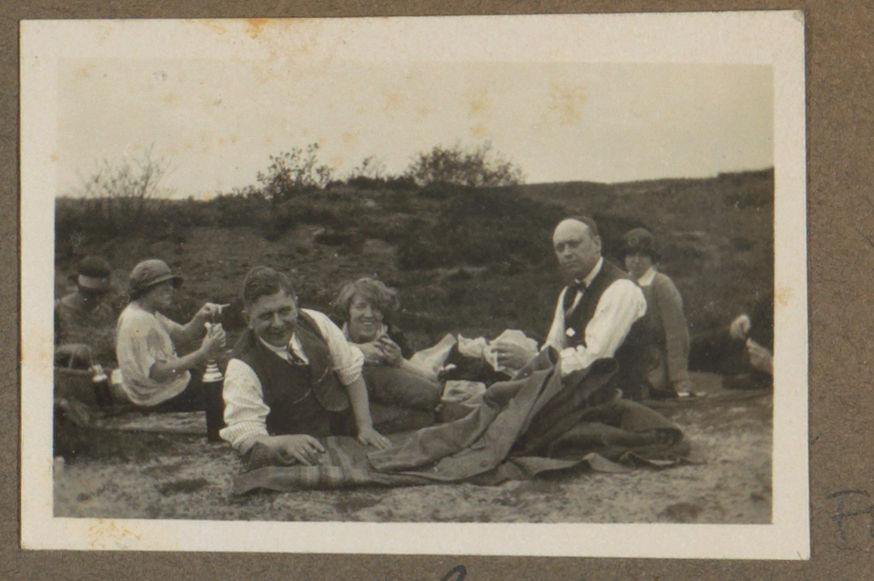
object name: photograph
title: 't schaftuur!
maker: Anonymous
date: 1905-1924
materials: photographic support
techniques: gelatin silver print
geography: amersfoort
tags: eating and drinking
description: Onderdeel van fotoalbum van een onbekende Nederlandse familie met opnames van Suriname, Europa en Nederlands-Indië.